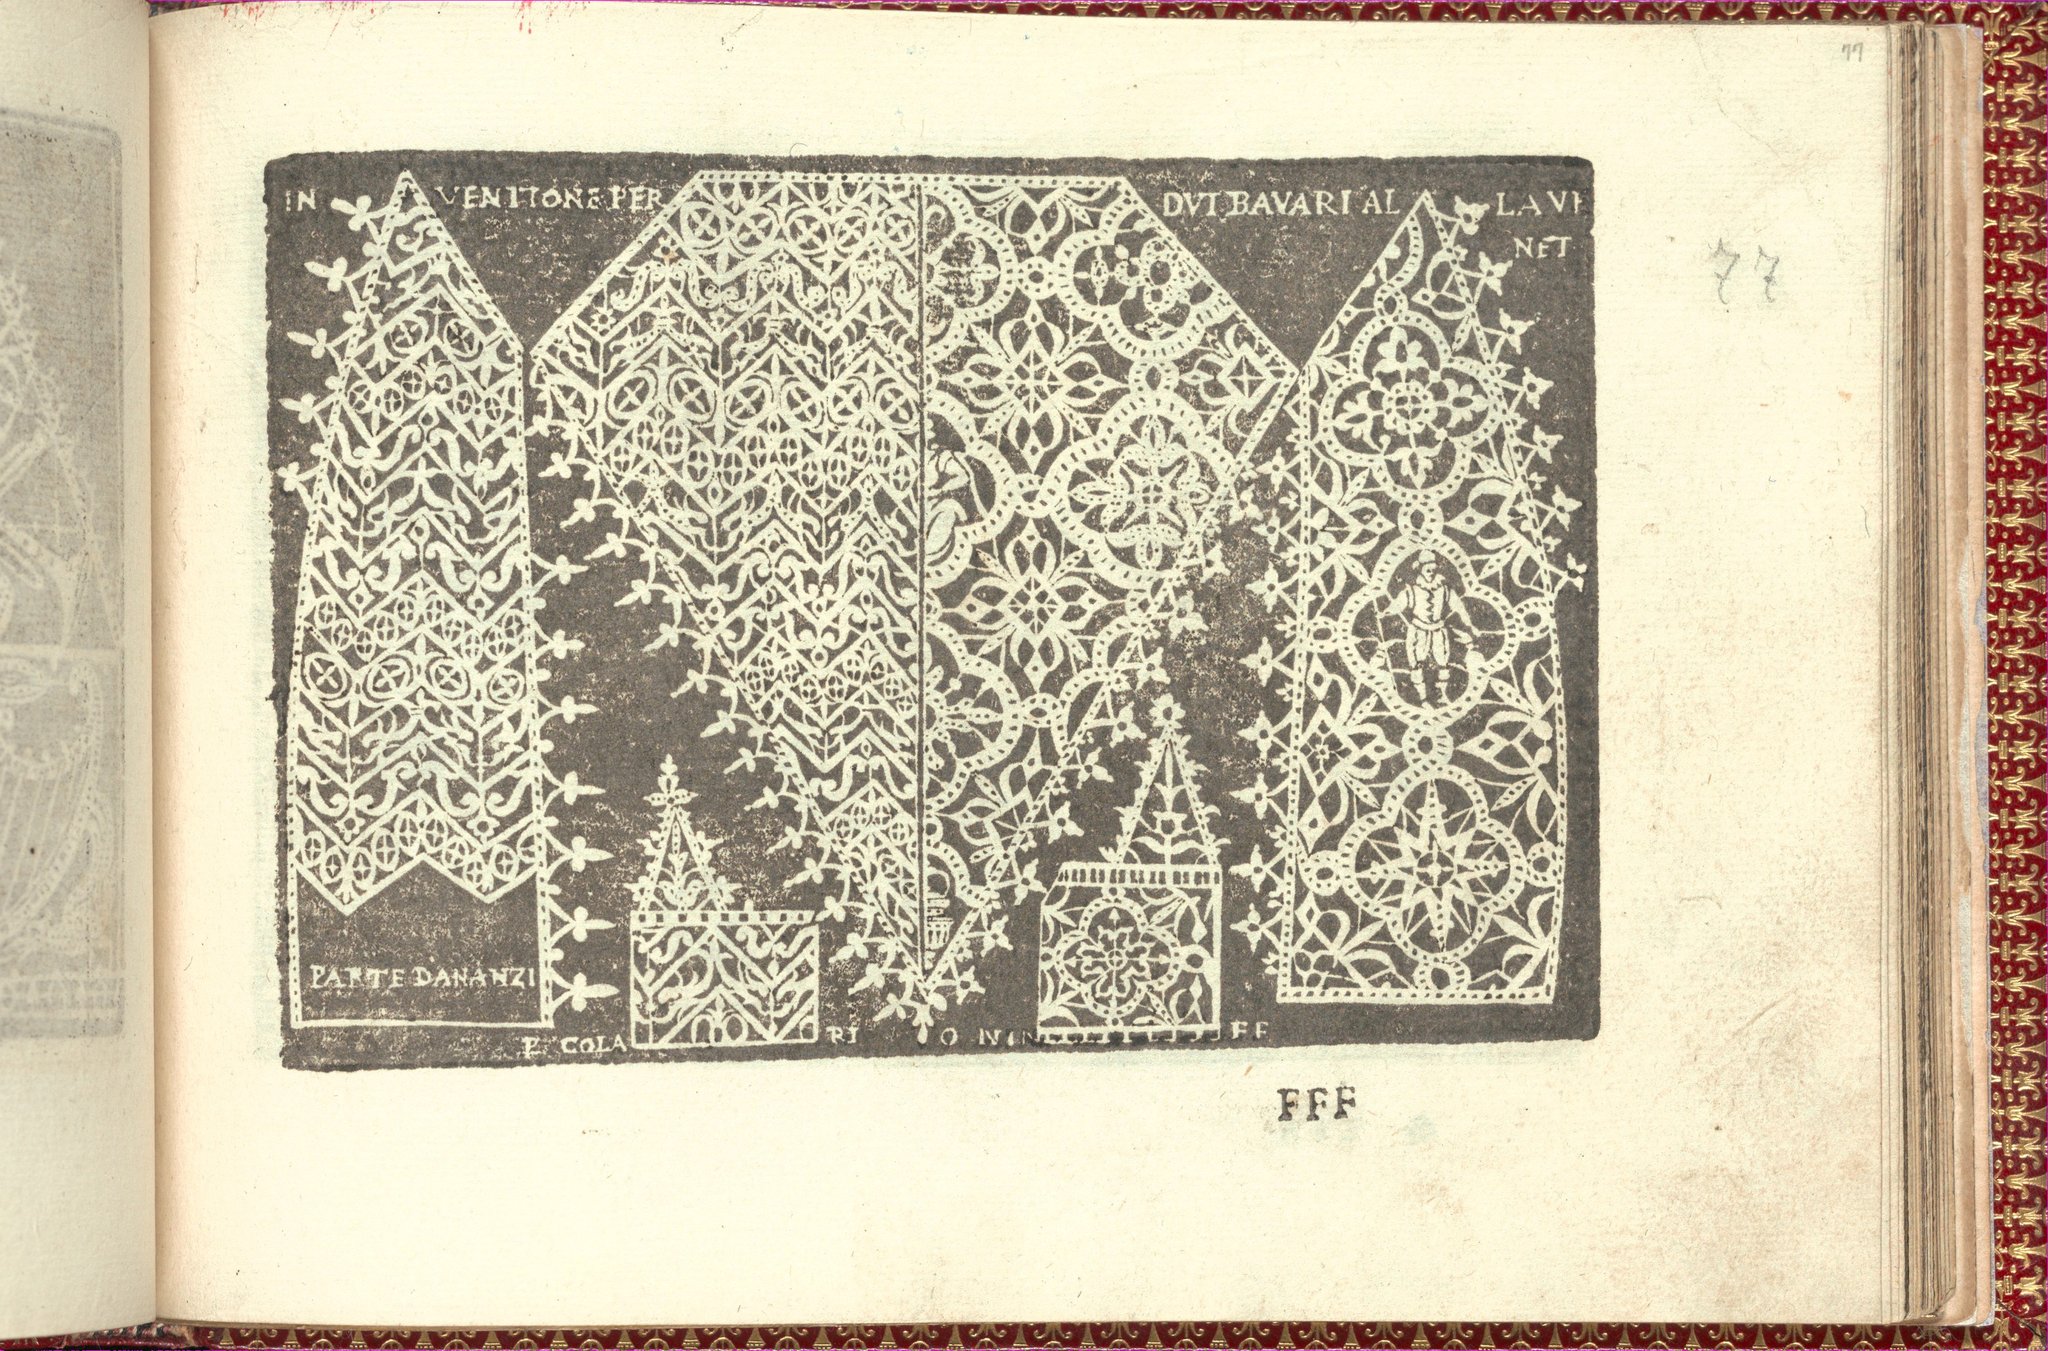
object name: book print ornament architecture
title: Corona delle Nobili et Virtuose Donne: Libro I-IV, page 77 (recto)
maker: cesare vecellio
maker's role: publisher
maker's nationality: italian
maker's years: 1521-1601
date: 1601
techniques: woodcut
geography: italy